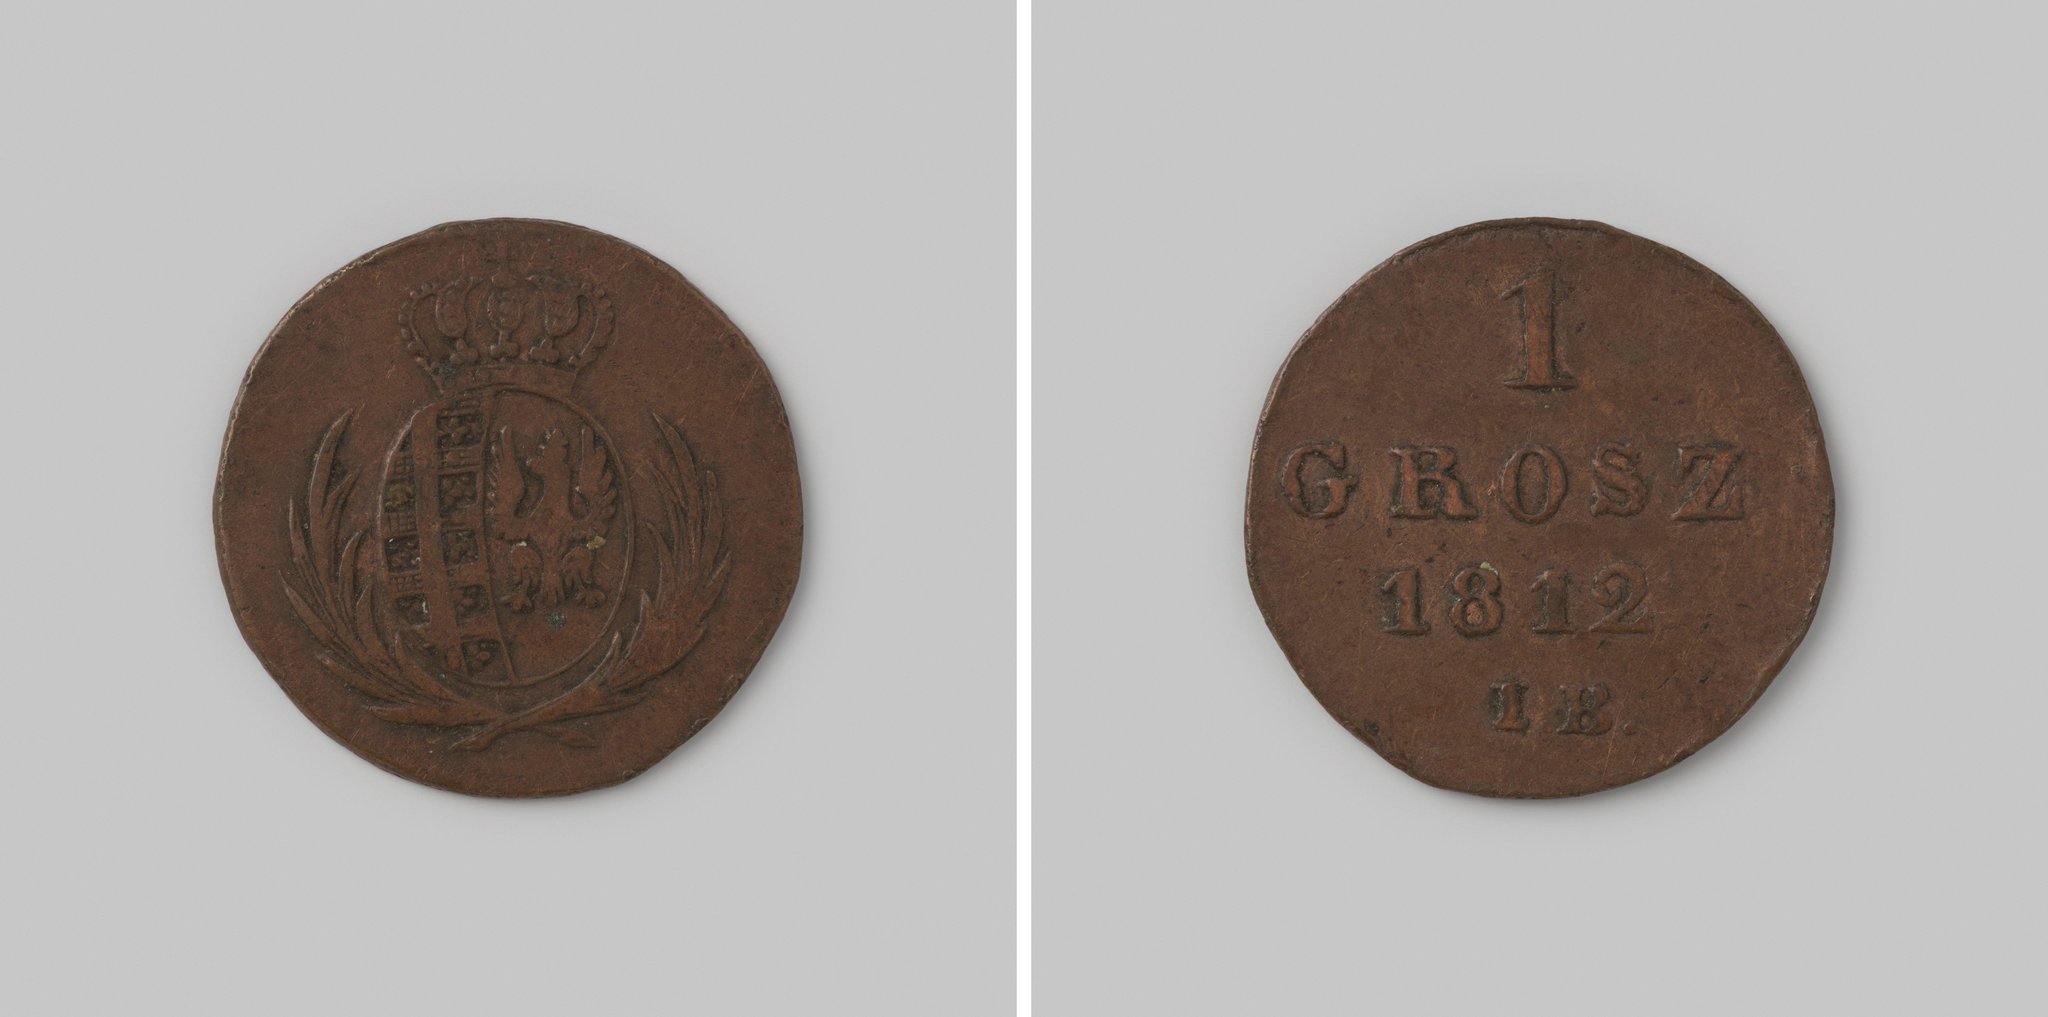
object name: coin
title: Hertogdom Warschau in Polen, Friedrich August van Saksen, grosz,1812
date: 1812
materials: copper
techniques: striking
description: Koperen munt. Voorzijde: tussen twee gekruiste takken gekroond samengesteld wapenschild. Keerzijde: in twee regels waarde-aanduiding, waaronder jaartal. Gladde rand.